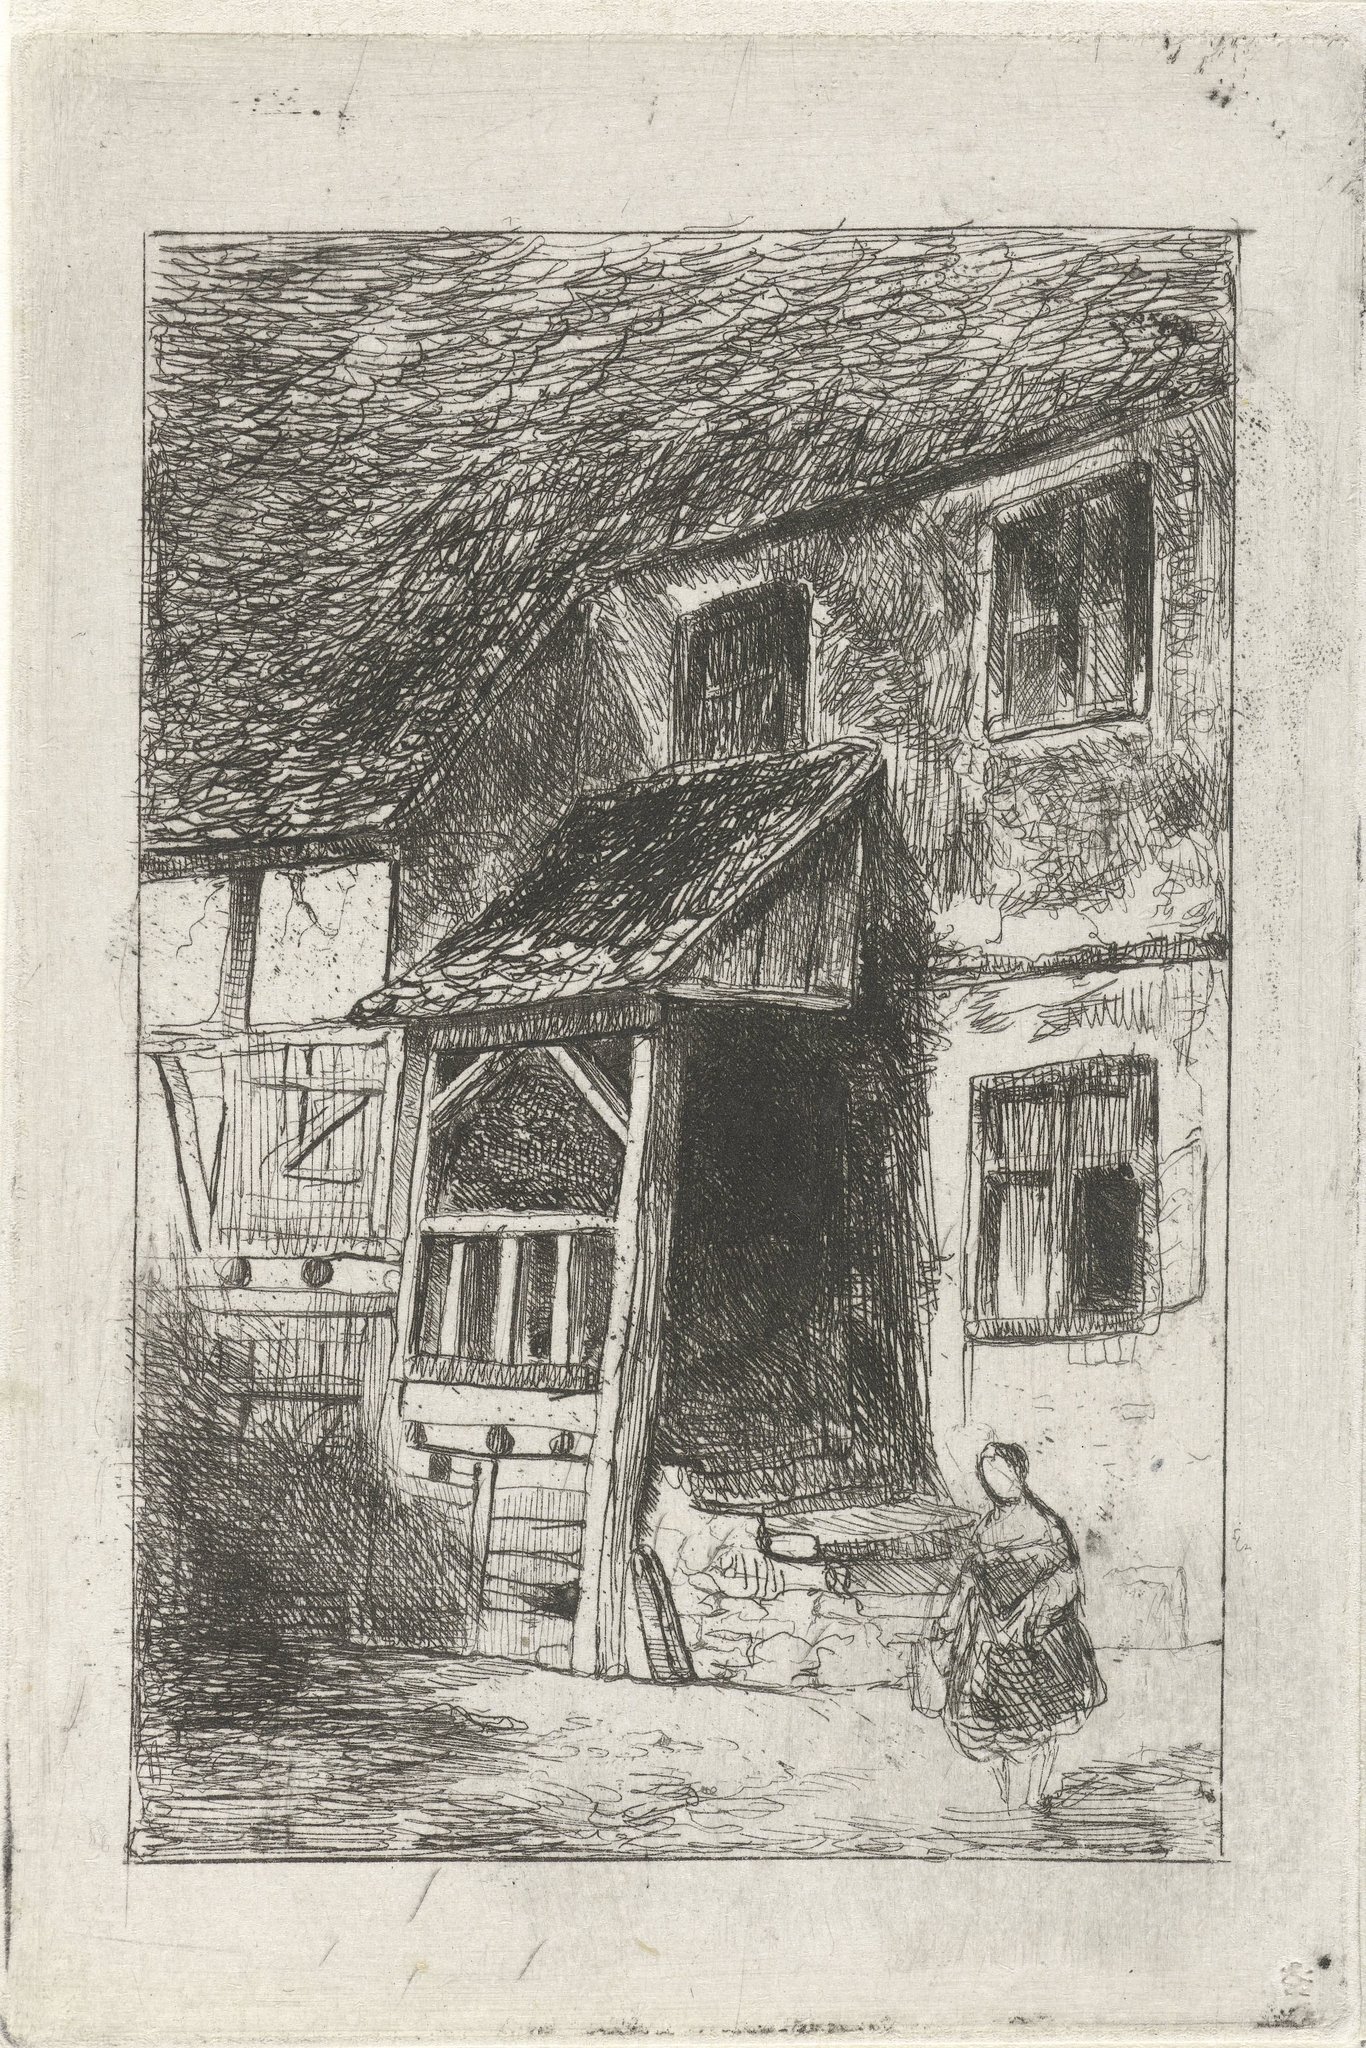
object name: print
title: Gevel van een huis met een overdekte opgang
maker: jan diederikus kruseman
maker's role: draughtsman, print maker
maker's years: 1828-1918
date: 1838-1882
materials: paper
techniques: etching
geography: netherlands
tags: façade (of house or building)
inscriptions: collector's mark: Lugt 2228, collector's mark: Lugt 2508